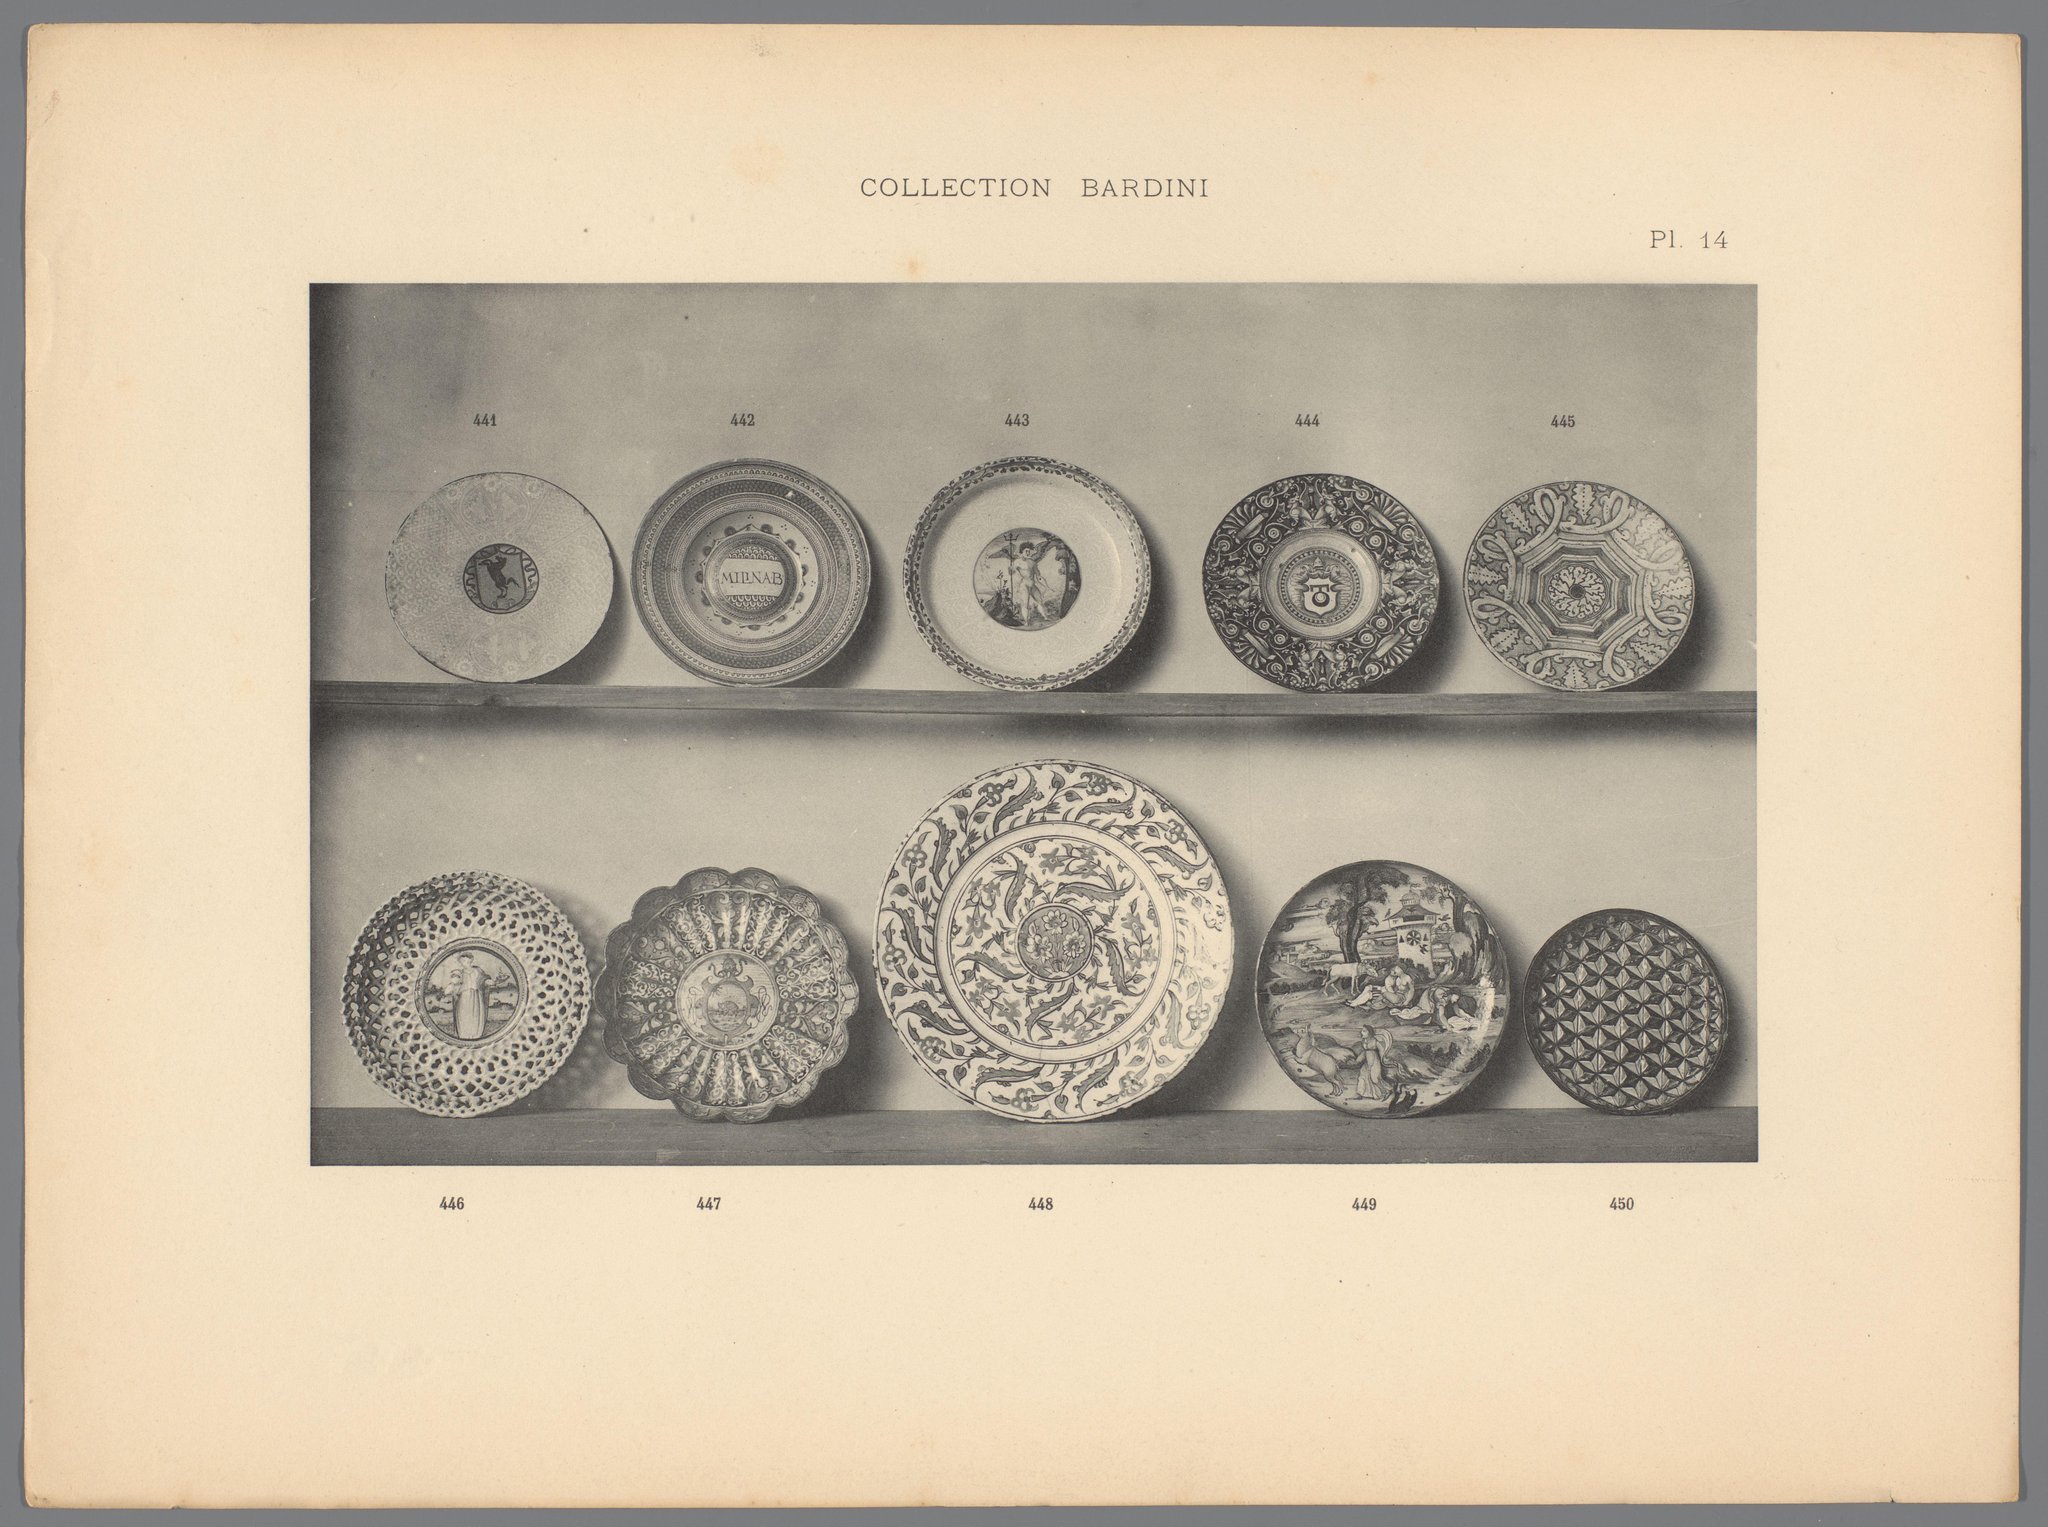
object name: photomechanical print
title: Verzameling gedecoreerde borden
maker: Anonymous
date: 1875-1930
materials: paper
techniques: photograph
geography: florence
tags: dish, plate, saucer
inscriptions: number: ‘Pl. 14’